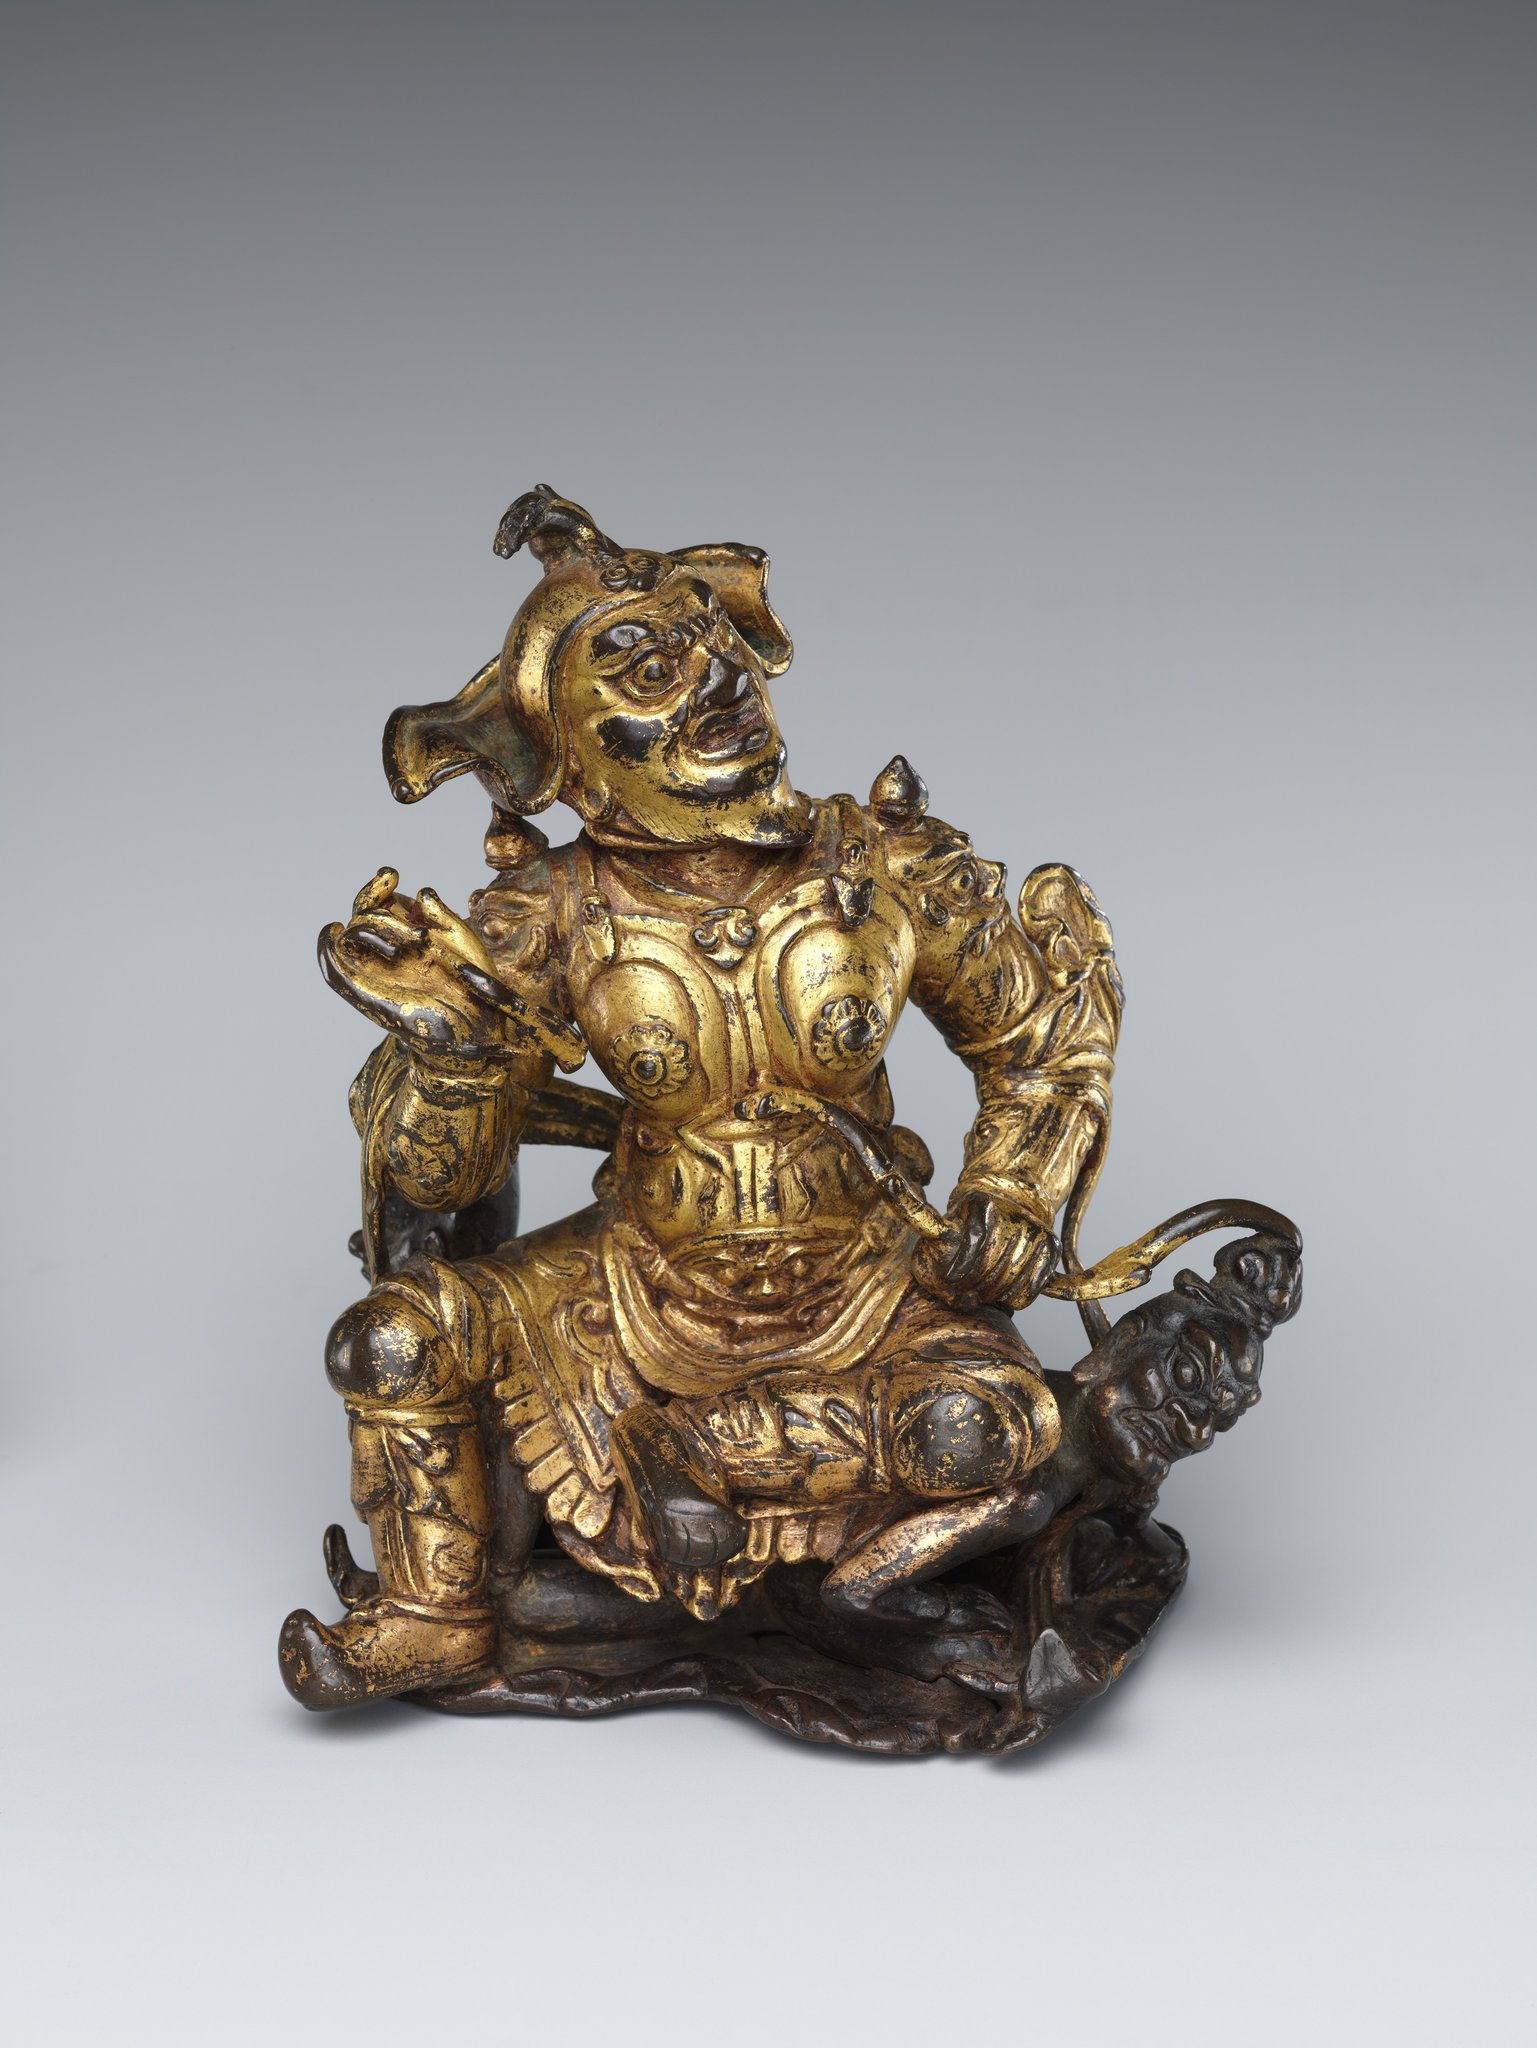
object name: figure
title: Guardian Protector of the East (Dongfang chiguo tianwang)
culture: chinese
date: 1001-1200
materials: bronze, gilt, wax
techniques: casting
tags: men,buddhism,demons